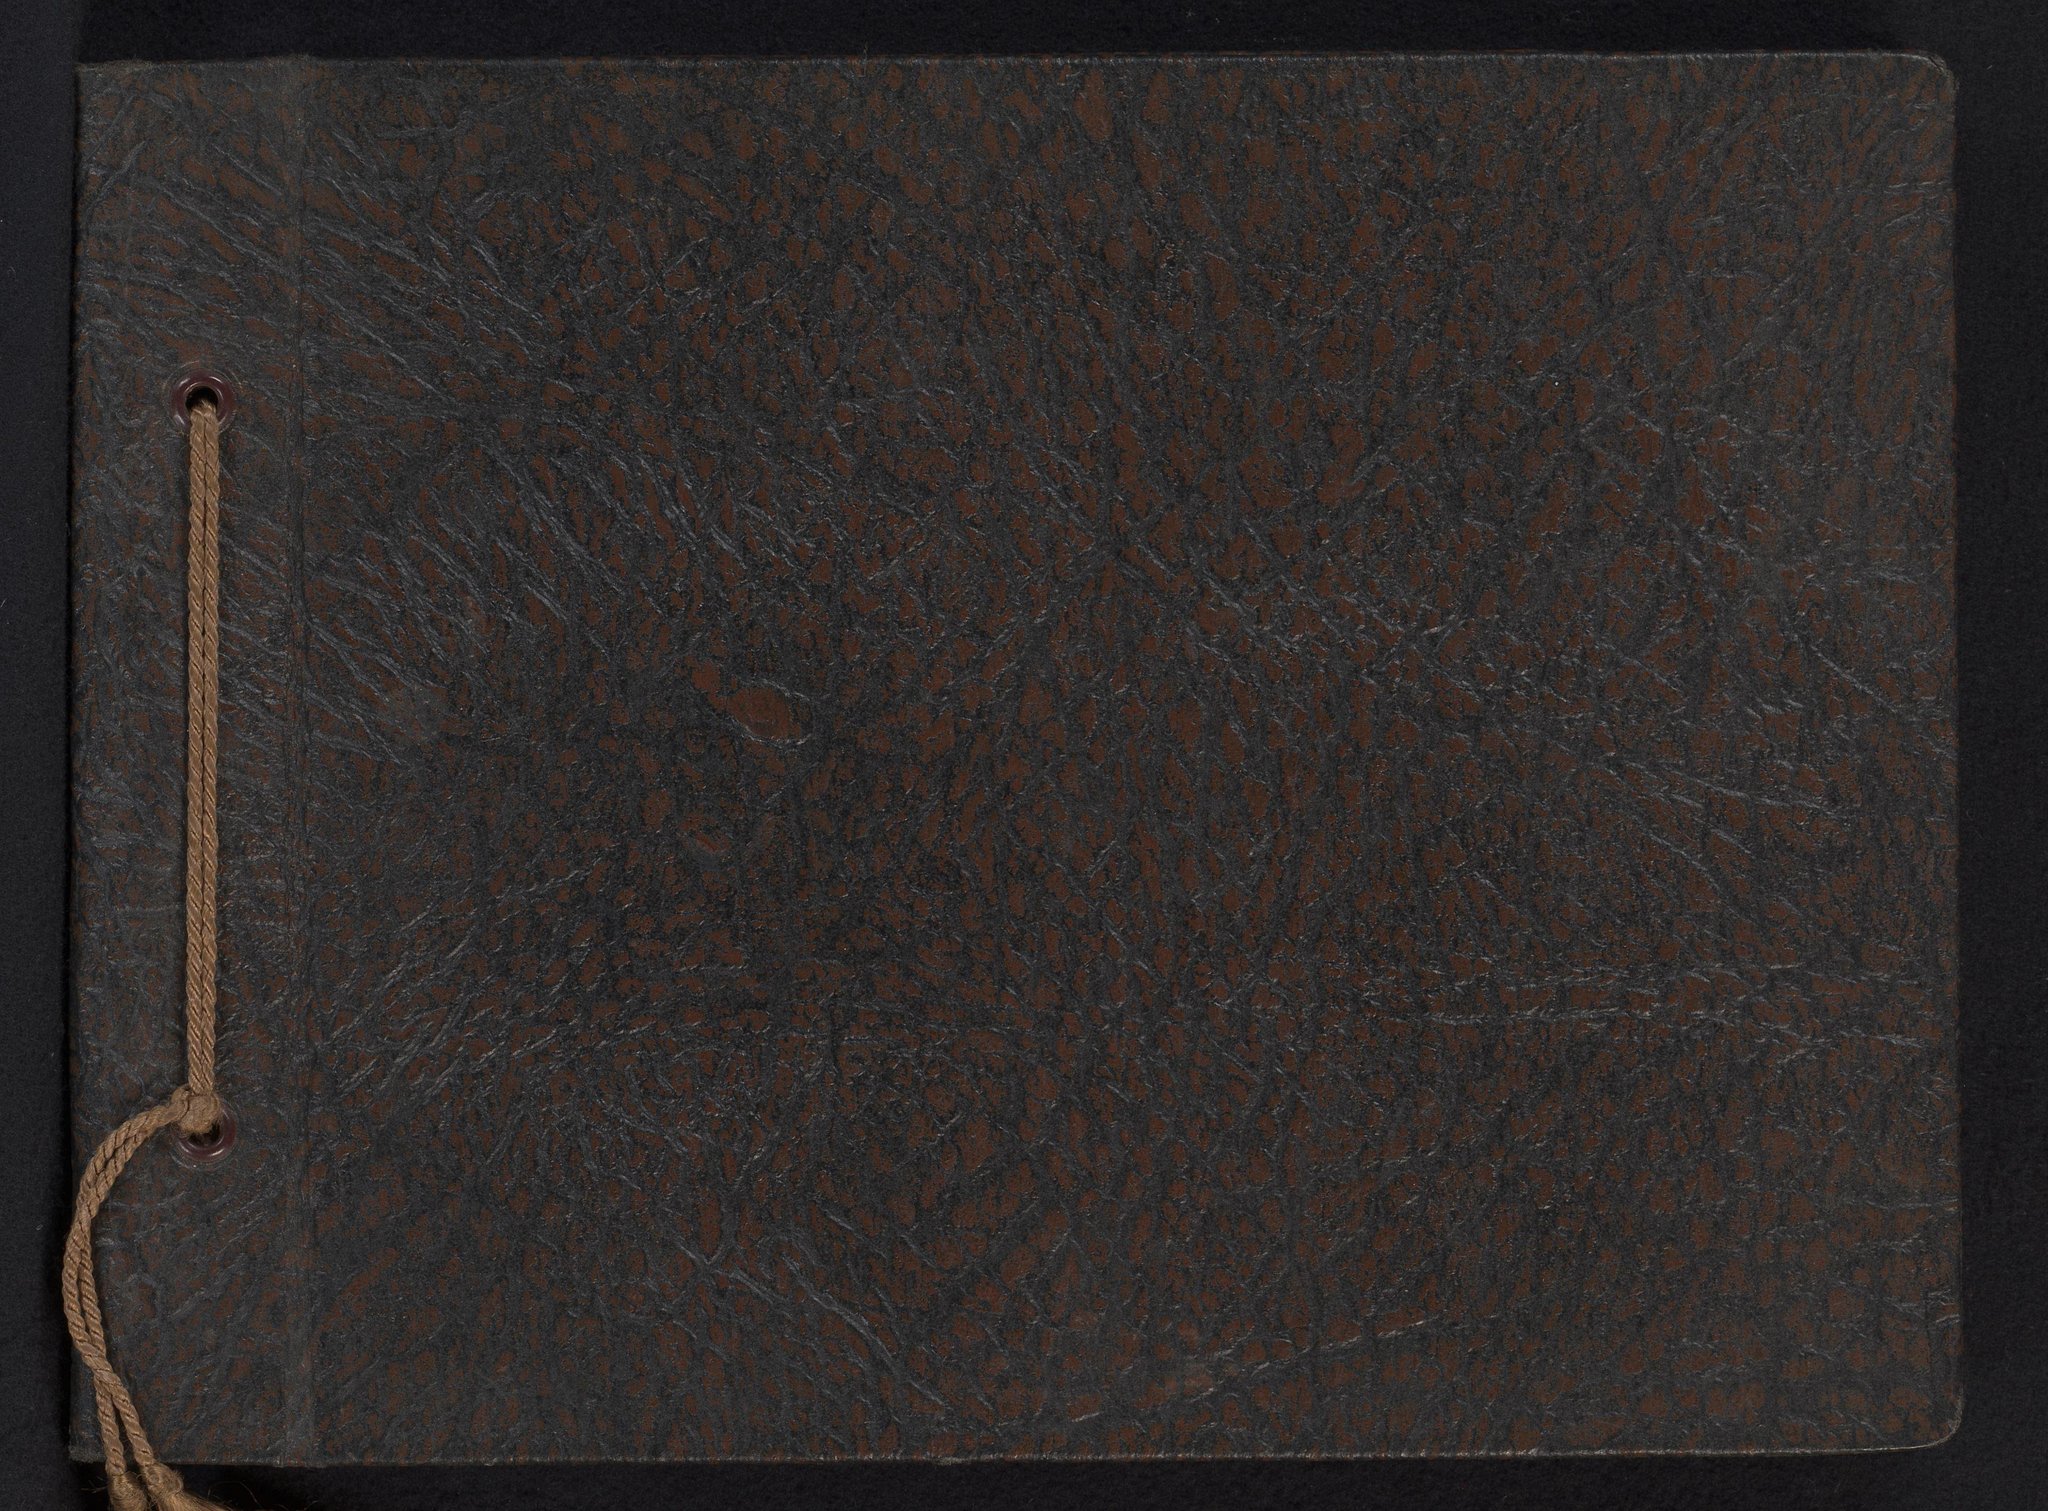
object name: scrapbook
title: Reisalbum Nederlands-Indië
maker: adeline andrea. du celliée muller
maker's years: 1899-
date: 1930-1940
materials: cardboard, leather, paper, photographic support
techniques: gelatin silver print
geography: dutch east indies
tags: animal traction, animal-drawn vehicle (carriage etc.), places and objects of worship ~ hinduism, buddhism, jainism, portrait of dancer, sawahs, rice paddies, ploughing, dutch east indies, the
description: Fotoalbum met 24 pagina's met in totaal 12 foto's. Alle foto's zijn gemaakt in Nederlands-Indië. Het album bevat foto's van onder meer de Borobudur, werk op rijstvelden en portretten van dansers en danseressen. Los voorin het album zit een vel met toelichtingen op de foto's.